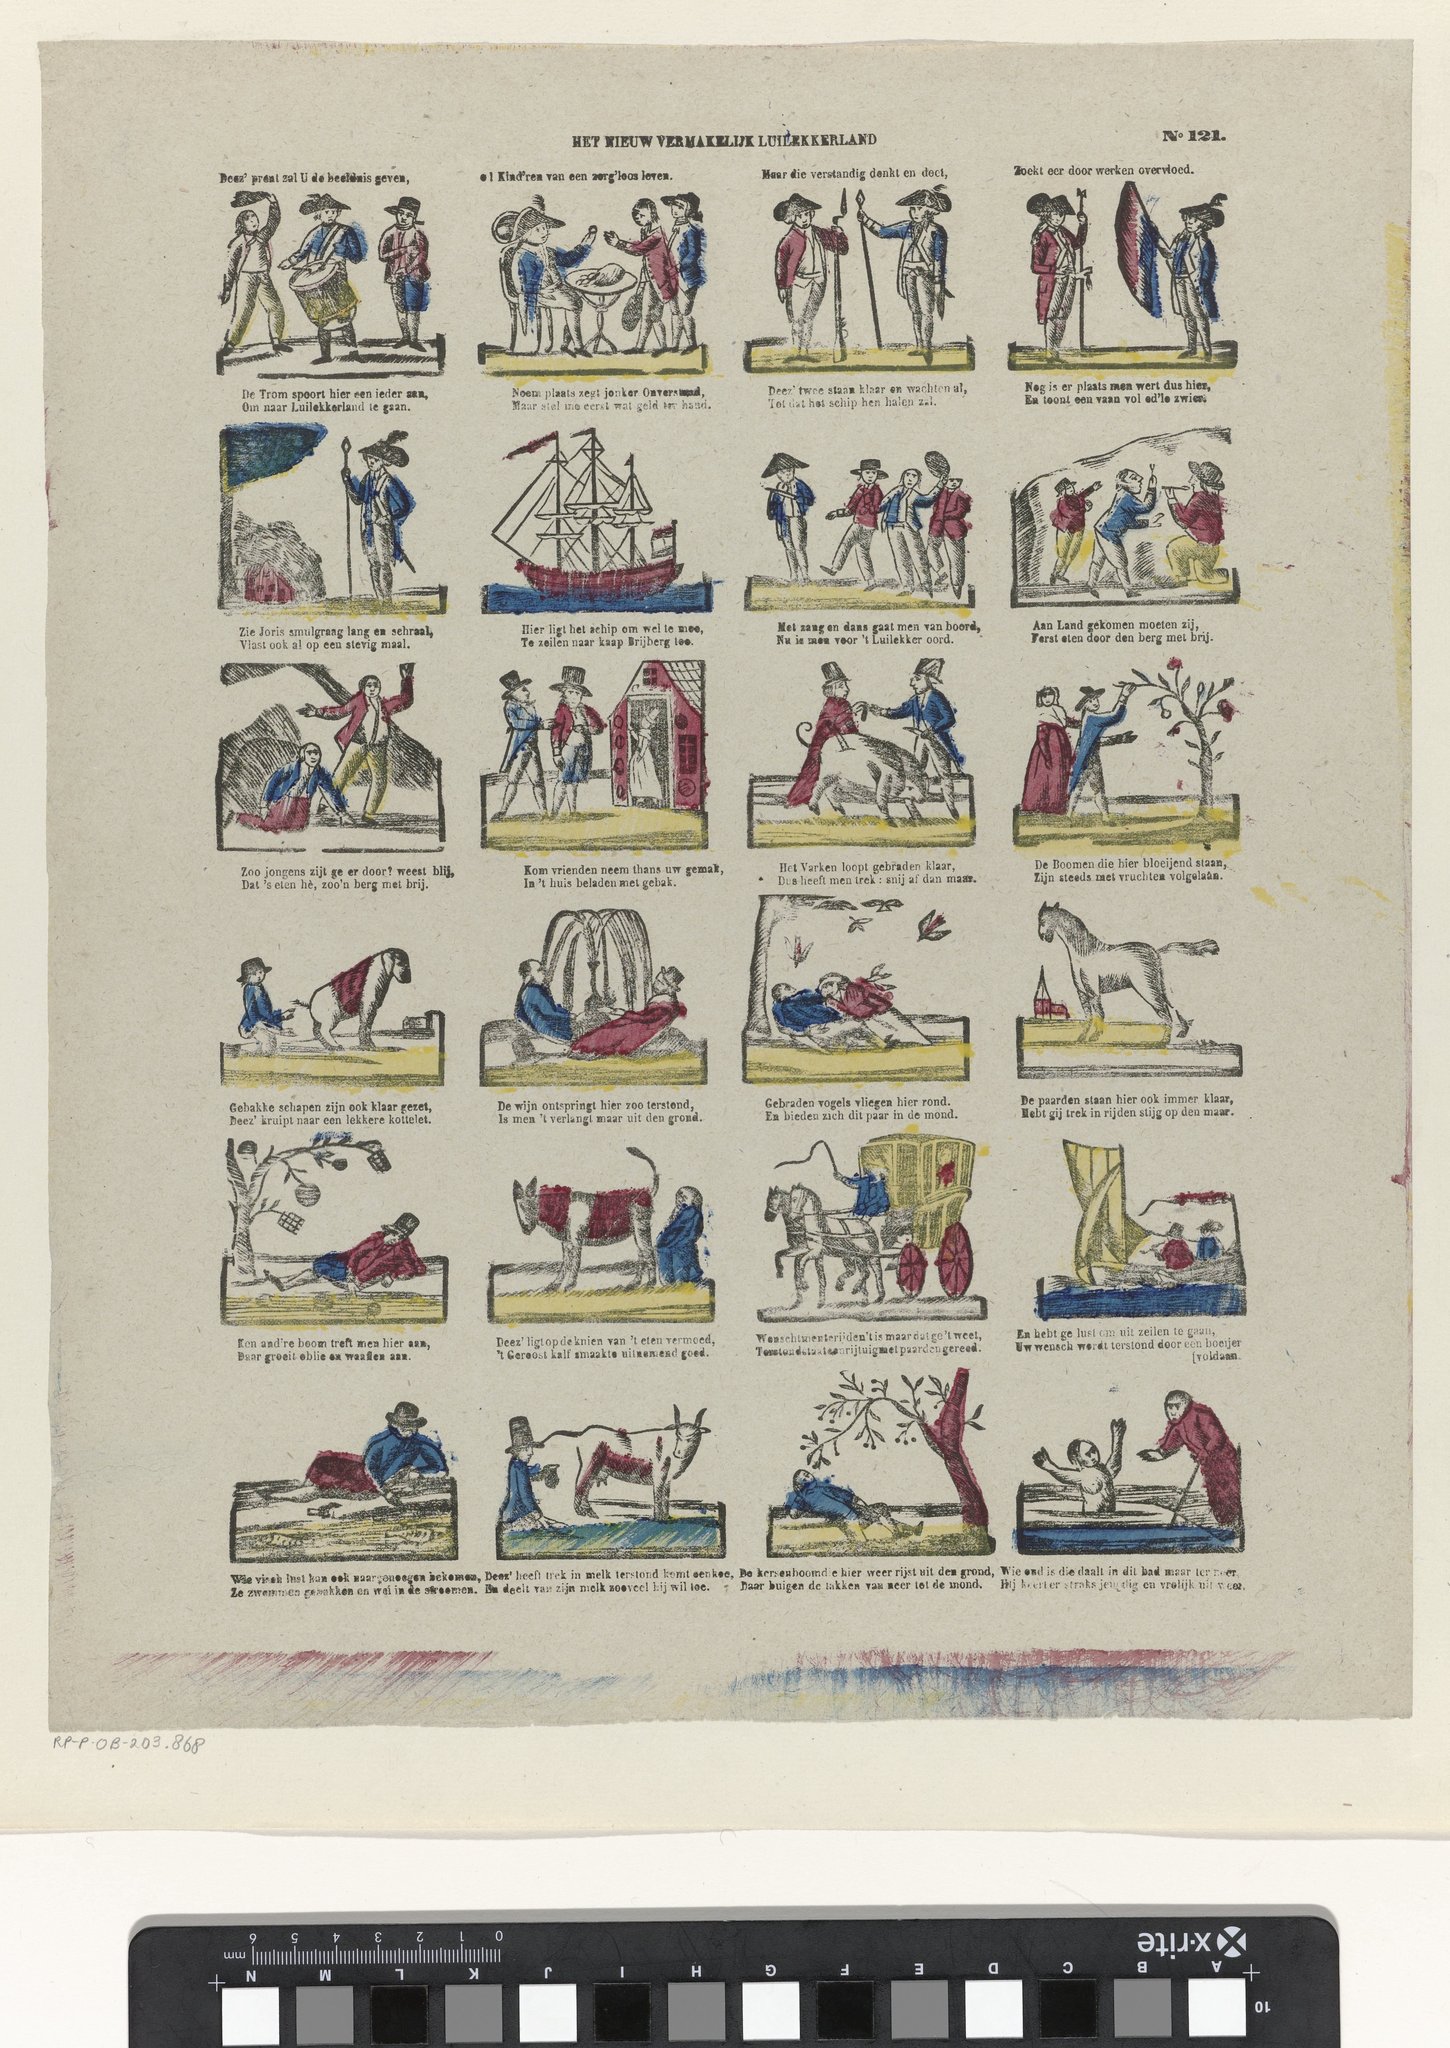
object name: popular print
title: Het nieuw vermakelijk luilekkerland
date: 1827-1894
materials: paper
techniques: colour, letterpress printing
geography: schaarbeek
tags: land of cockaigne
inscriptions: collector's mark: Lugt 2760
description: Blad met 24 voorstellingen van het Luilekkerland. Onder elke afbeelding een tweeregelig vers. Genummerd rechtsboven: No 121.